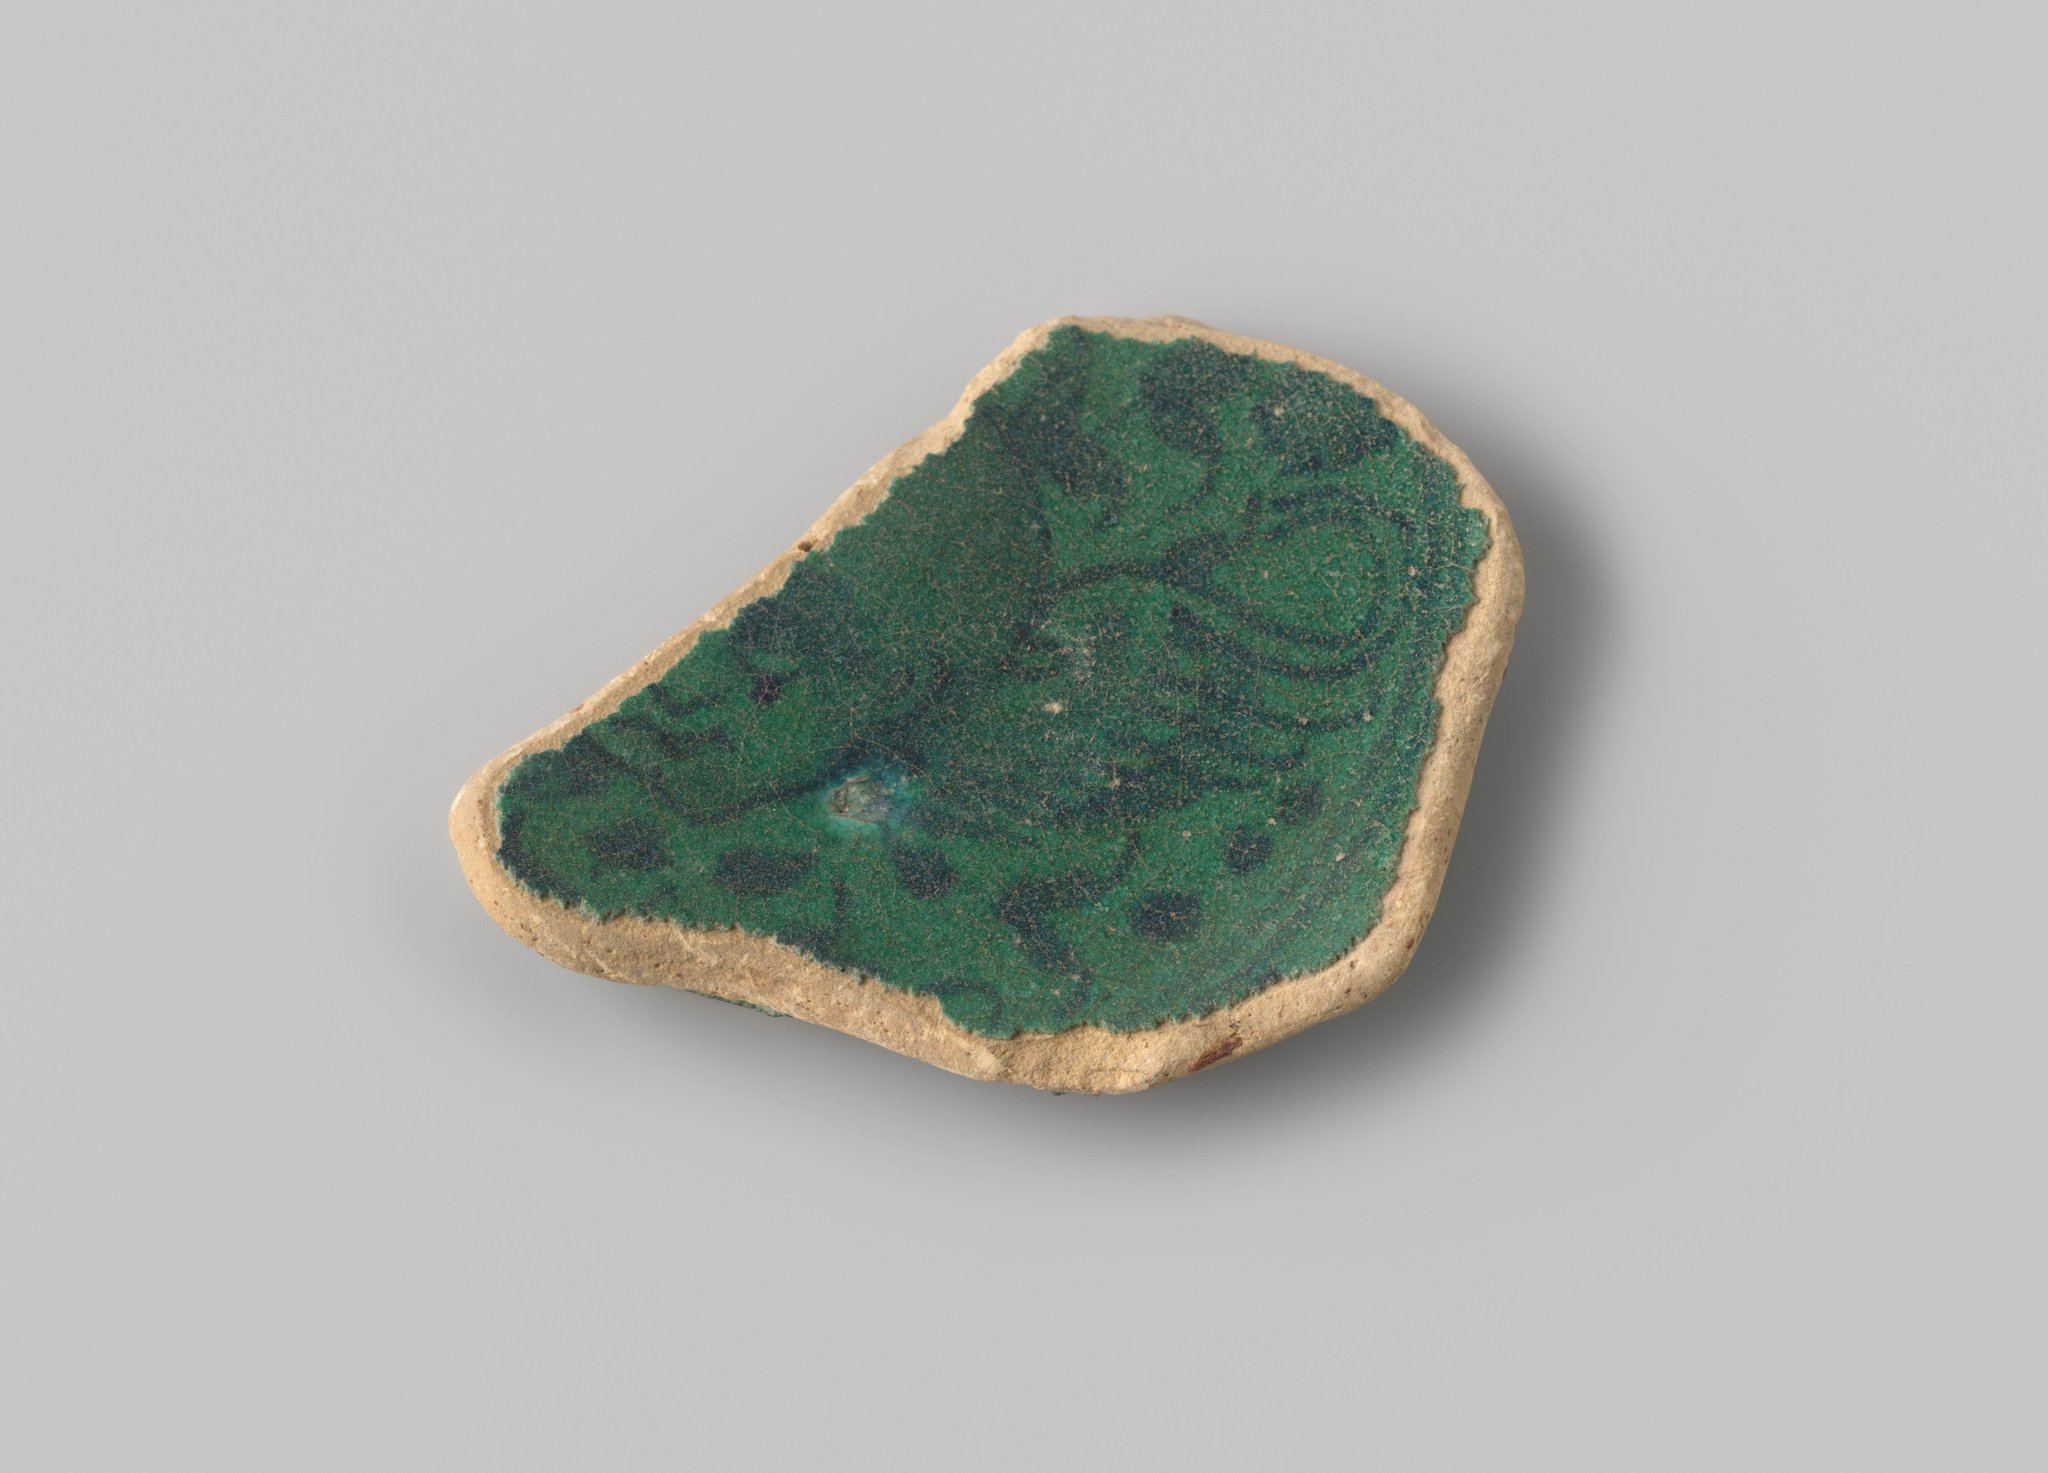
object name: sherd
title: Fragment (voet) met grijs-gele scherf, op donkergroenglazuur in zwart een tekening van een engelenkopje met vleugels (één zichtbaar) en ranken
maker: Anonymous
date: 1200-1899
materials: earthenware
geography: italy